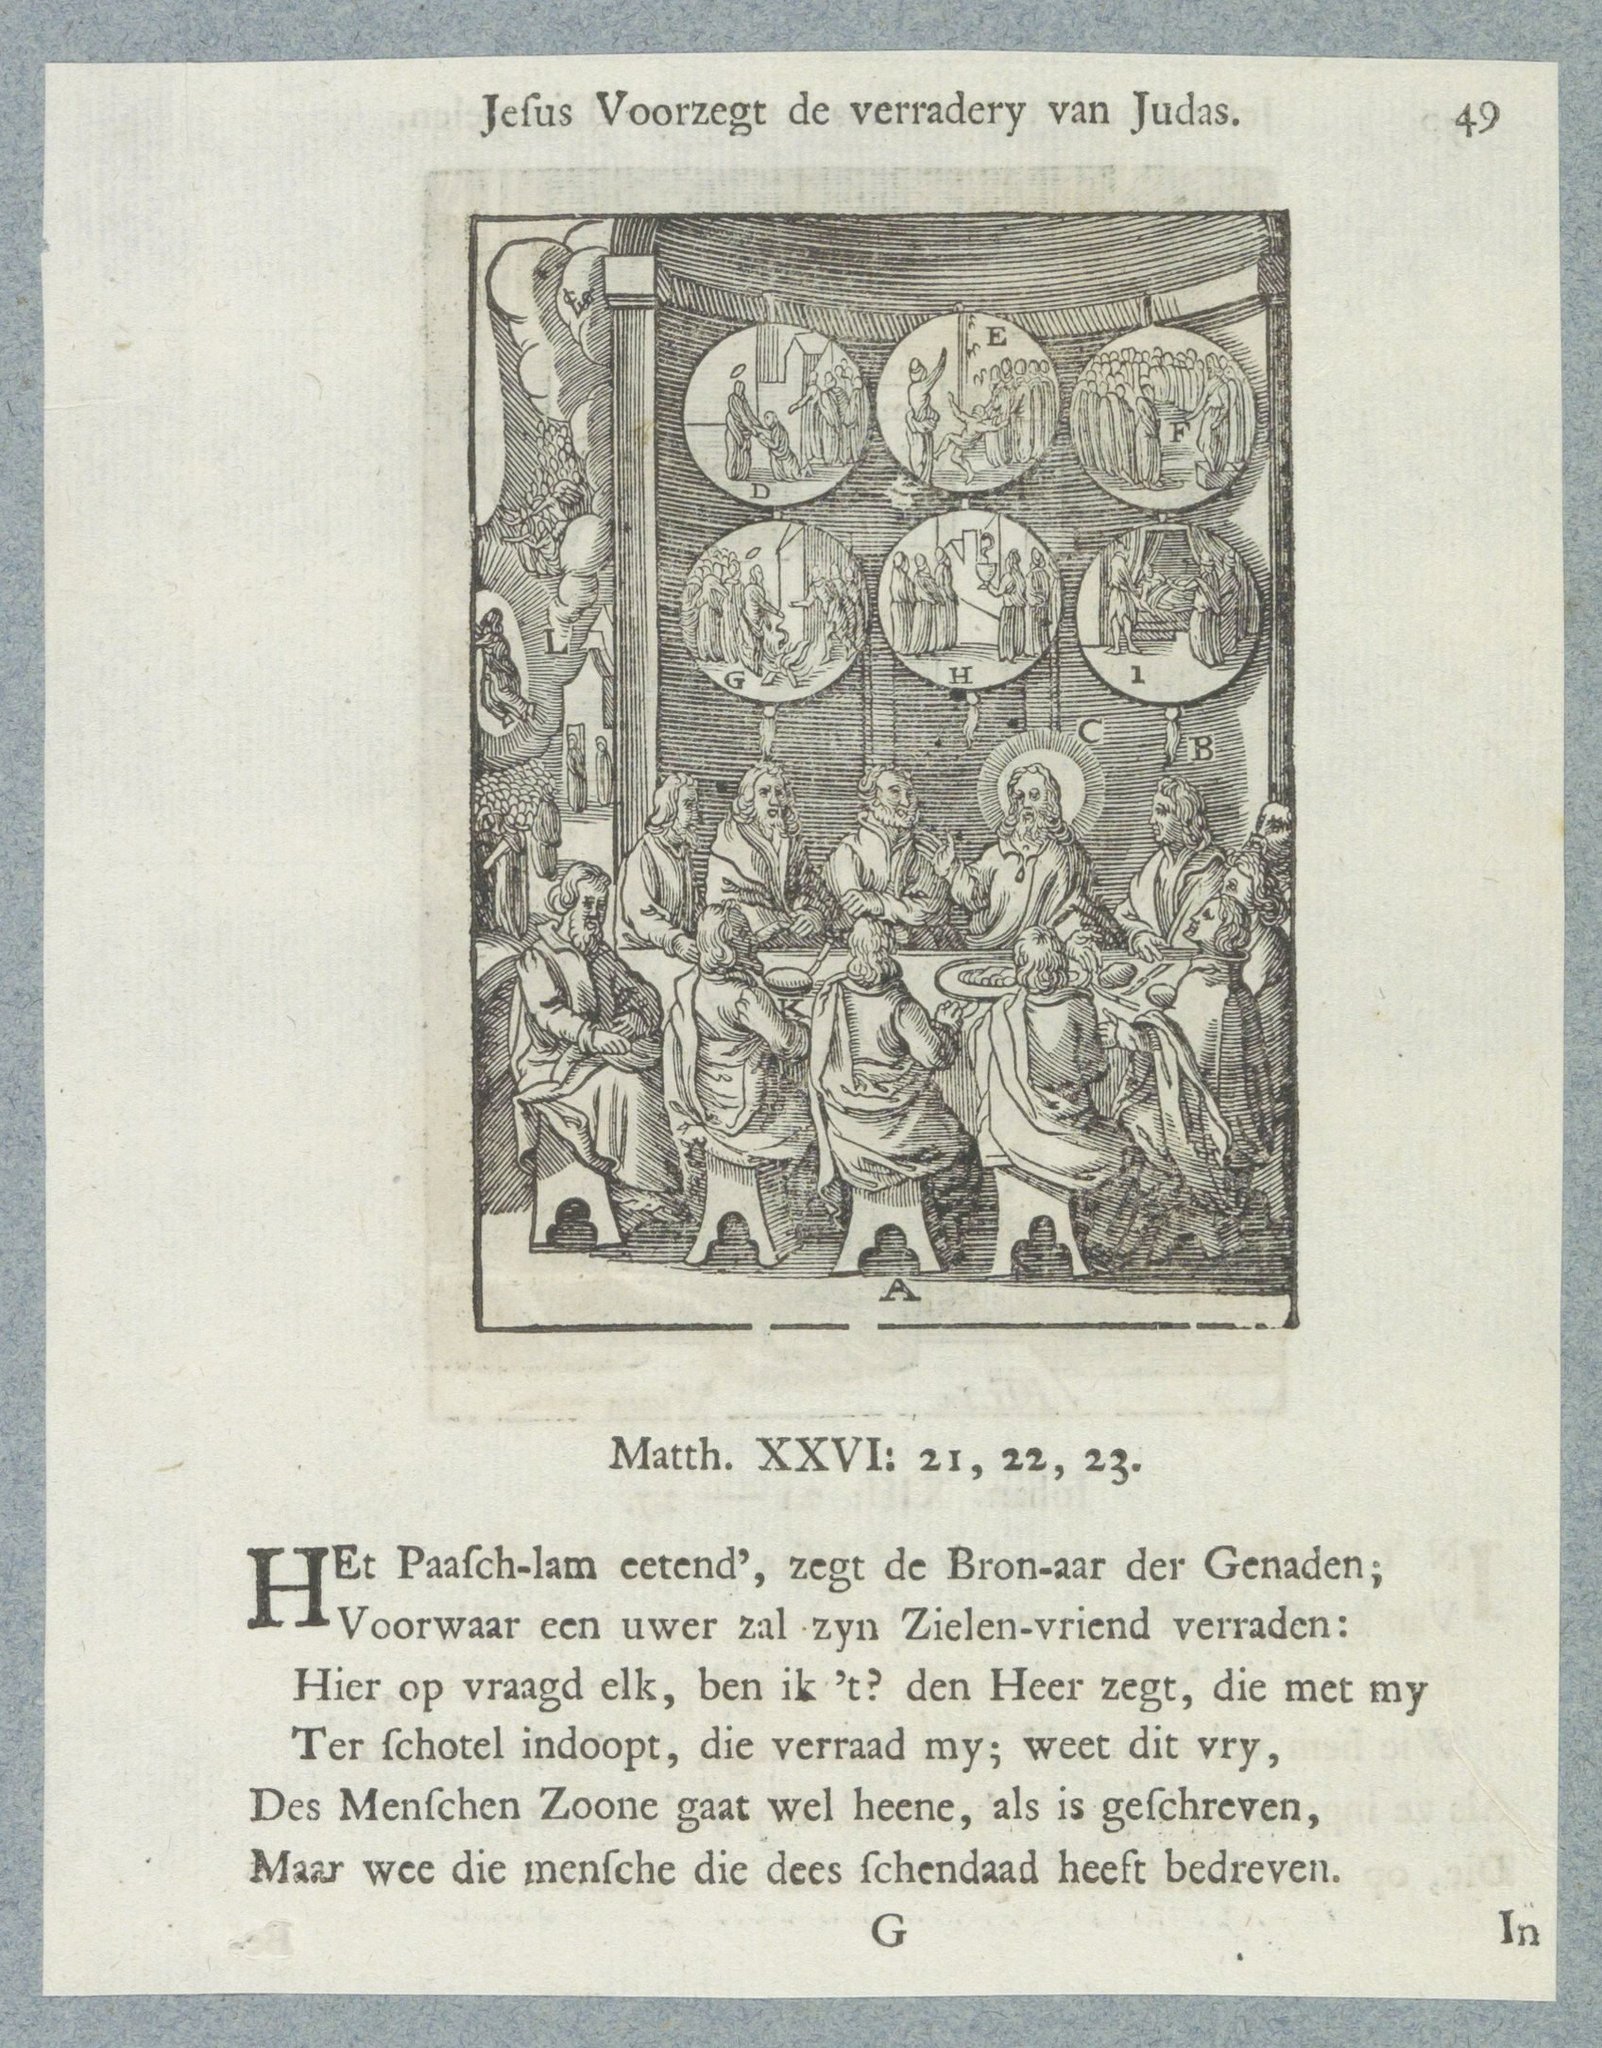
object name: album leaf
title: Jesus voorzegt de verradery van Judas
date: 1629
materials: paper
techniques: letterpress printing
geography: amsterdam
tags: the ascension (christ surrounded by radiant light or in a mandorla), christ at table with the apostles ~ after the resurrection, last supper (in general) (matthew 26:21-35; mark 14:18-31; luke 22:3, 22:15-23; john 13:21-38)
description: Christus verschijnt aan de apostelen terwijl ze aan het eten zijn. Hij verwijt hen hun ongeloof en halsstarrigheid en draagt hen op door de wereld te gaan. In de zes cirkels daarboven is de inhoud van het Evangelie verbeeld. Op de achtergrond is te zien hoe Christus in de hemel wordt opgenomen. Hier wordt de afbeelding gebruikt als voorstelling van het Laatste Avondmaal waar Christus voorspelt dat een van zijn discipelen hem uitleveren zal. Bij verschillende elementen uit de voorstelling staan letters. Boven de voorstelling een titel. Eronder zes versregels en een verwijzing naar Mattheüs 26: 21-23. De prent maakt deel uit van een album.